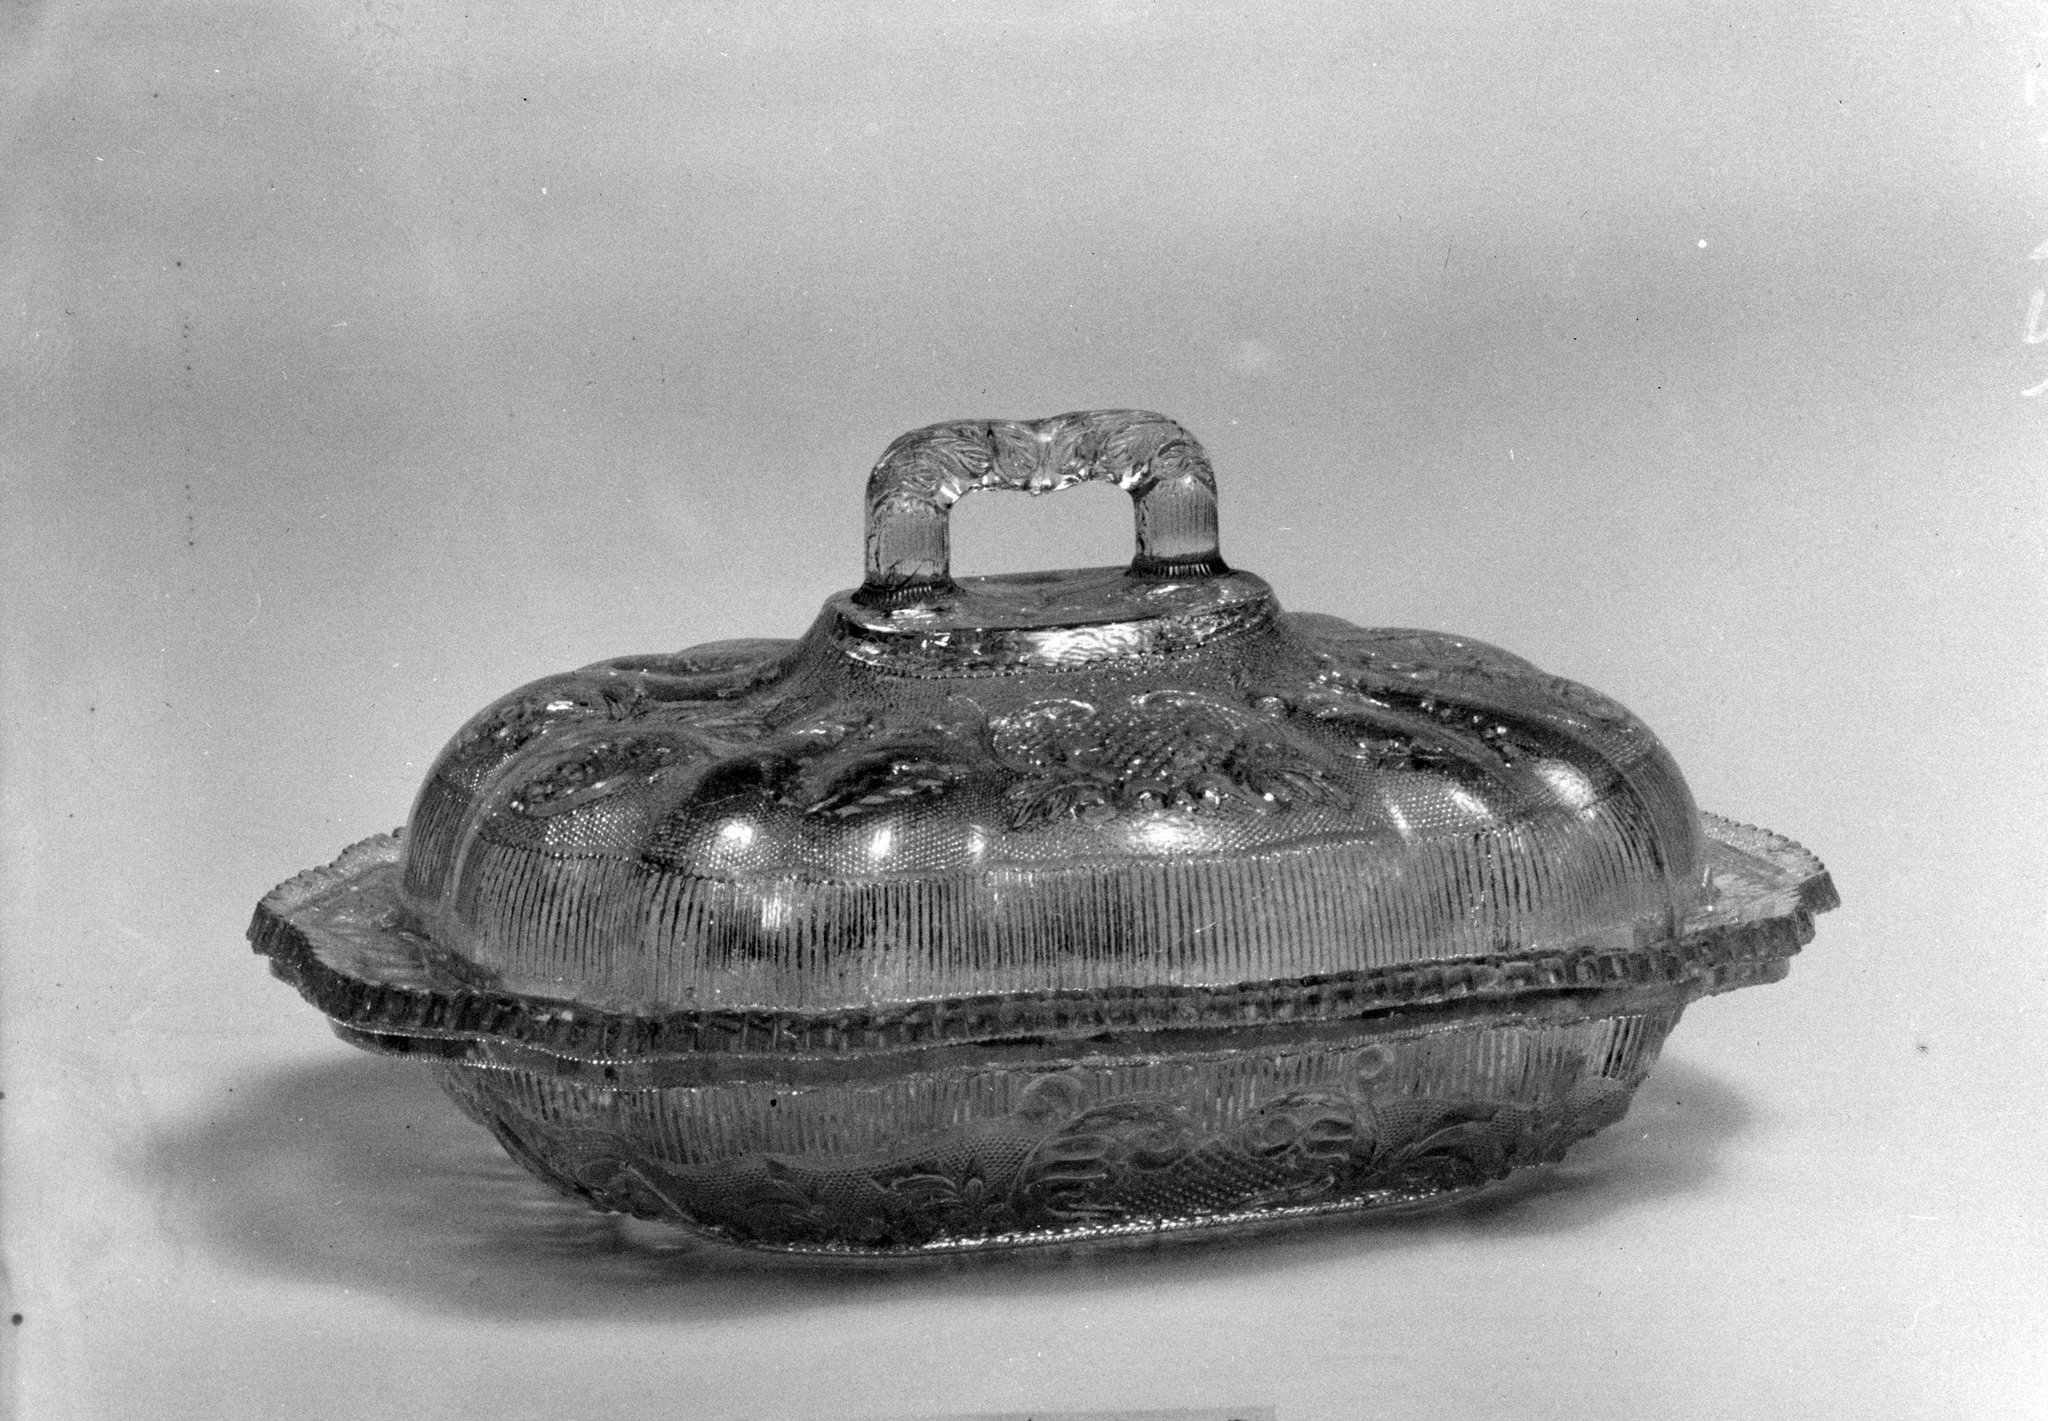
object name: vegetable dish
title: Covered Vegetable Dish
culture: american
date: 1830-1840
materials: glass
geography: united states